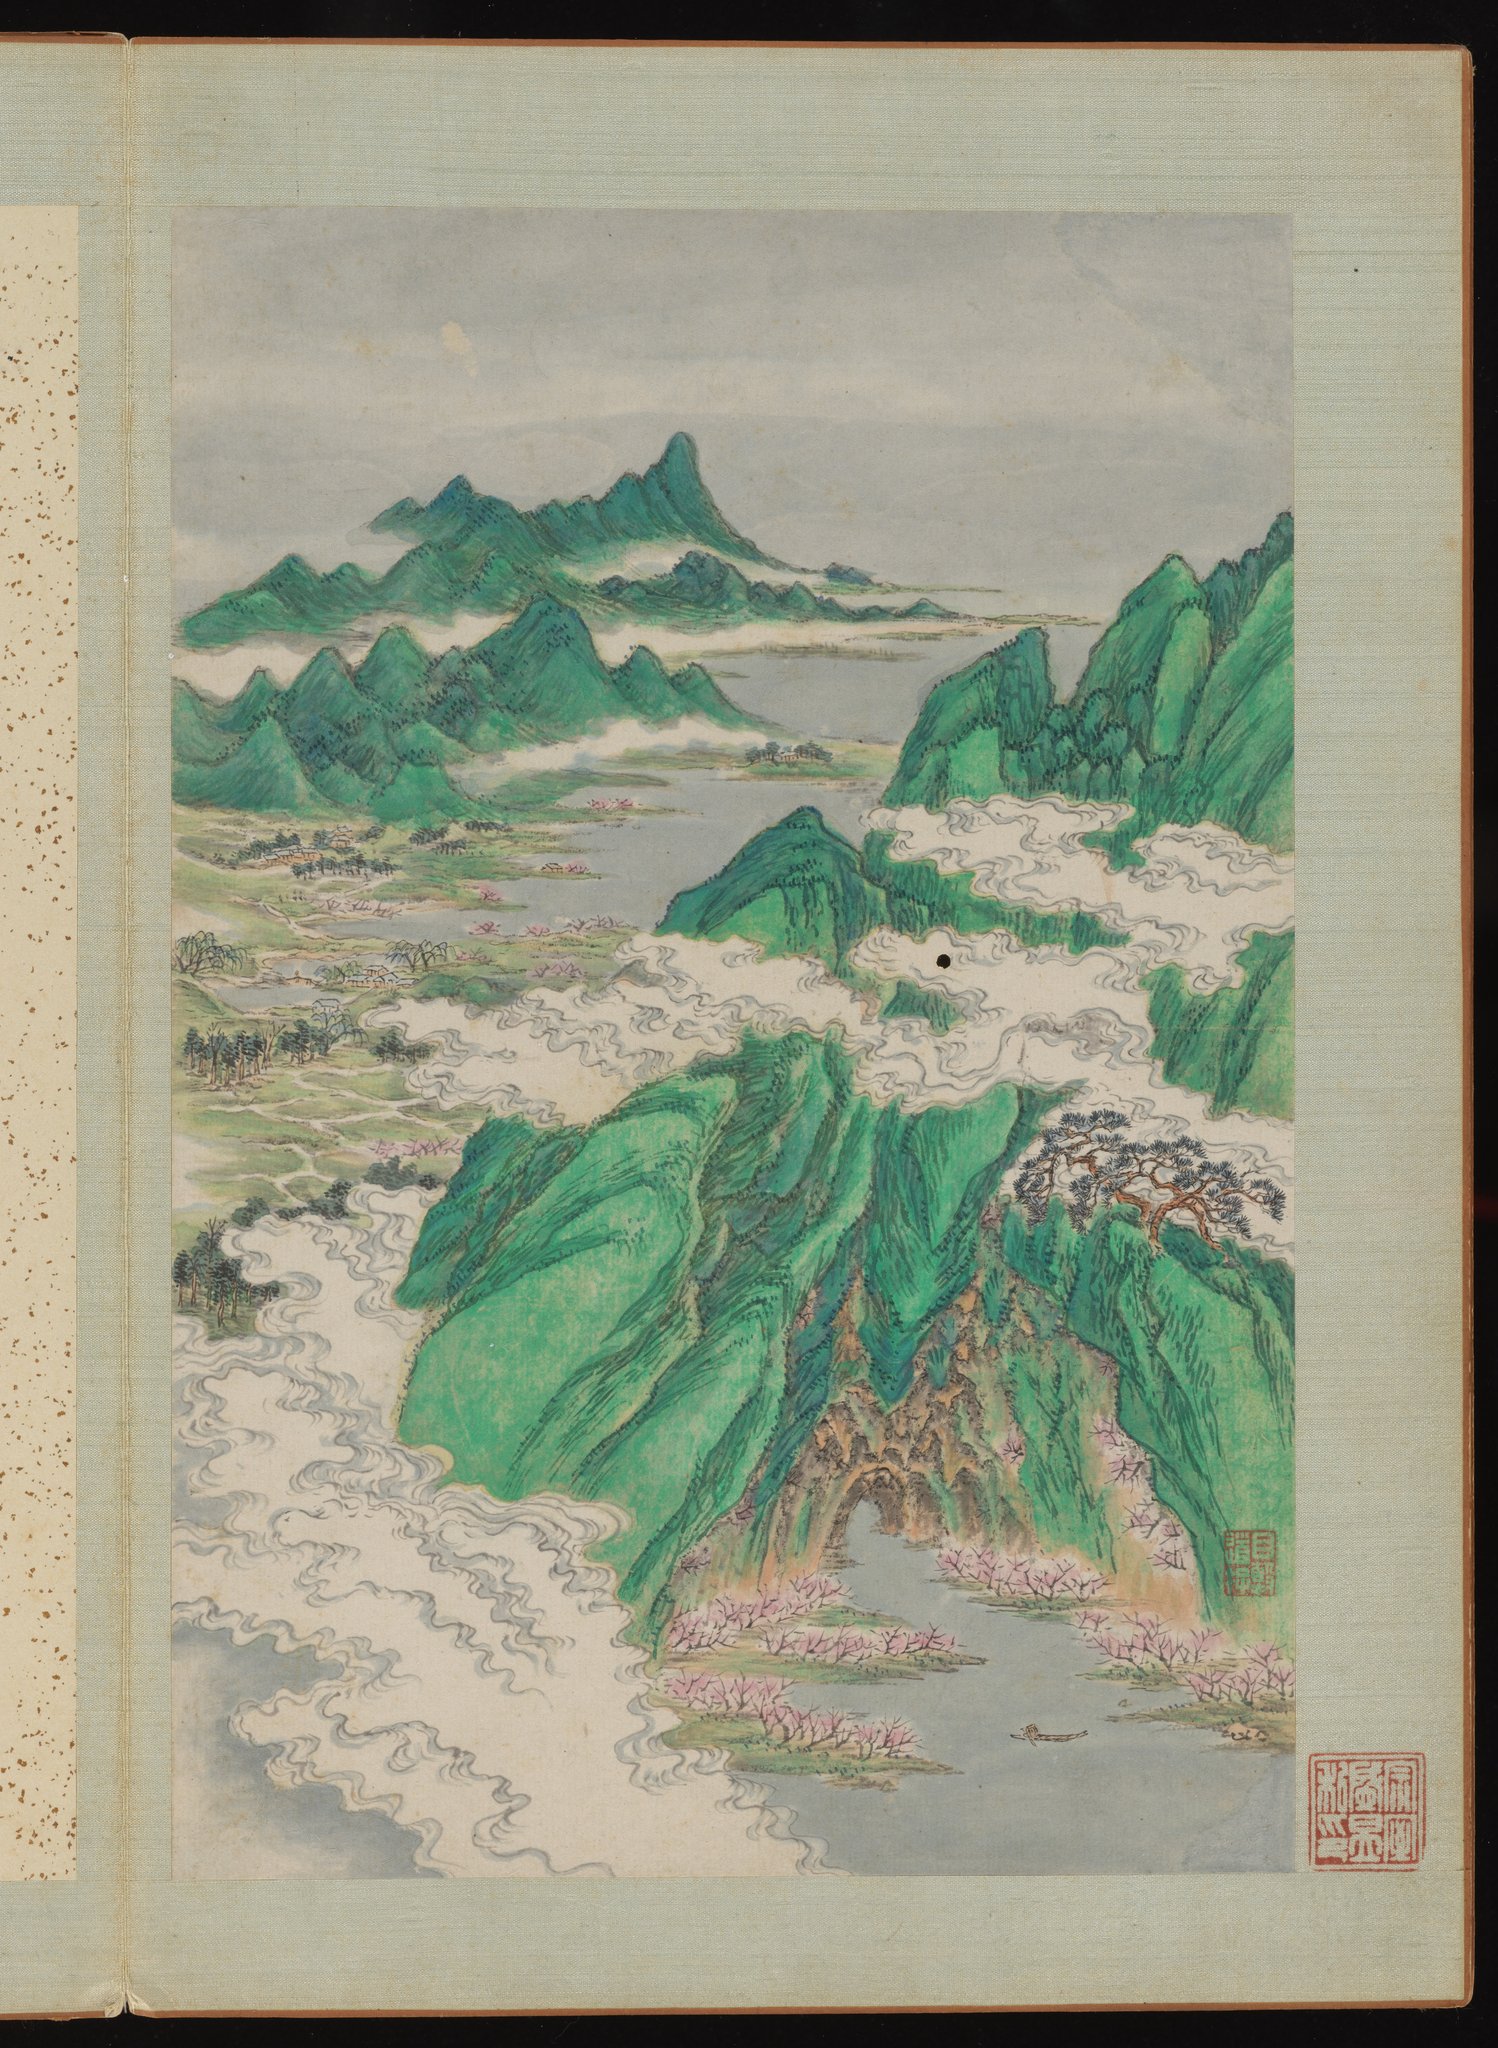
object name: album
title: Landscapes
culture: chinese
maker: shangrui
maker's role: artist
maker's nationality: chinese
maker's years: 1634-1734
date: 1672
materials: ink, paper